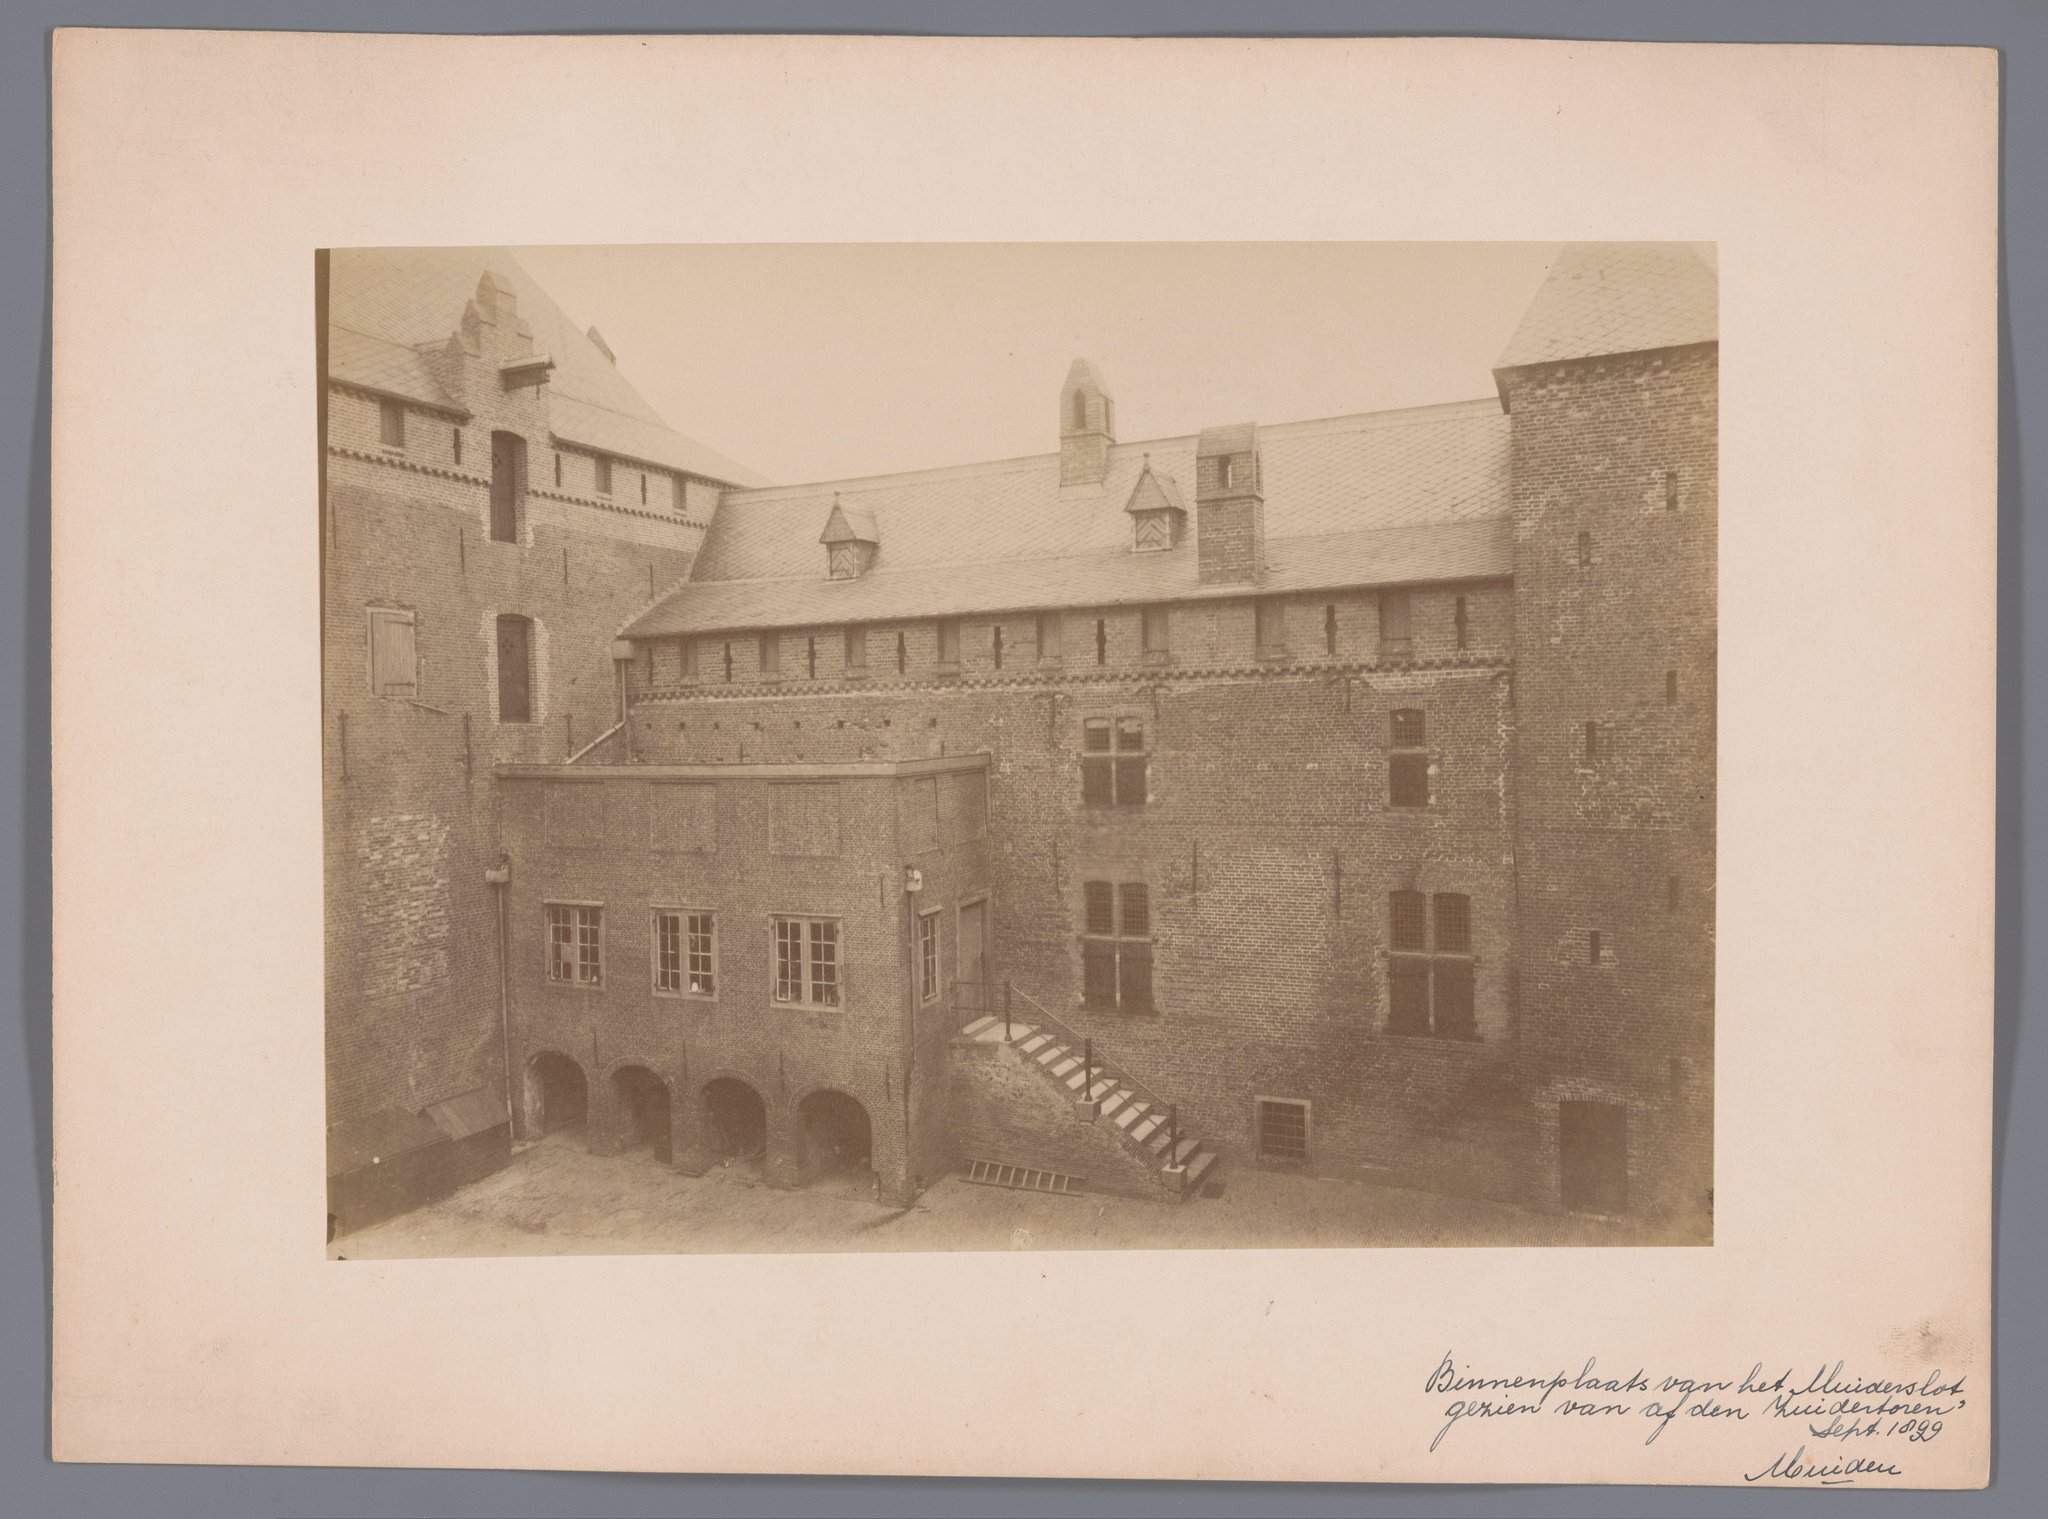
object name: photograph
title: Binnenplaats van het Muiderslot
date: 1899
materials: cardboard, photographic support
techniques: albumen print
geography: muiderslot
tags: castle, courtyard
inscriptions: annotation: ‘Binnenplaats van het slot te Muiden (N.H.)/ gezien van af der zuidertoren/ sept 99’, annotation: ‘Binnenplaats van het Muiderslot, gezien van af den Zuidertoren/ Sept. 1899/ Muiden’